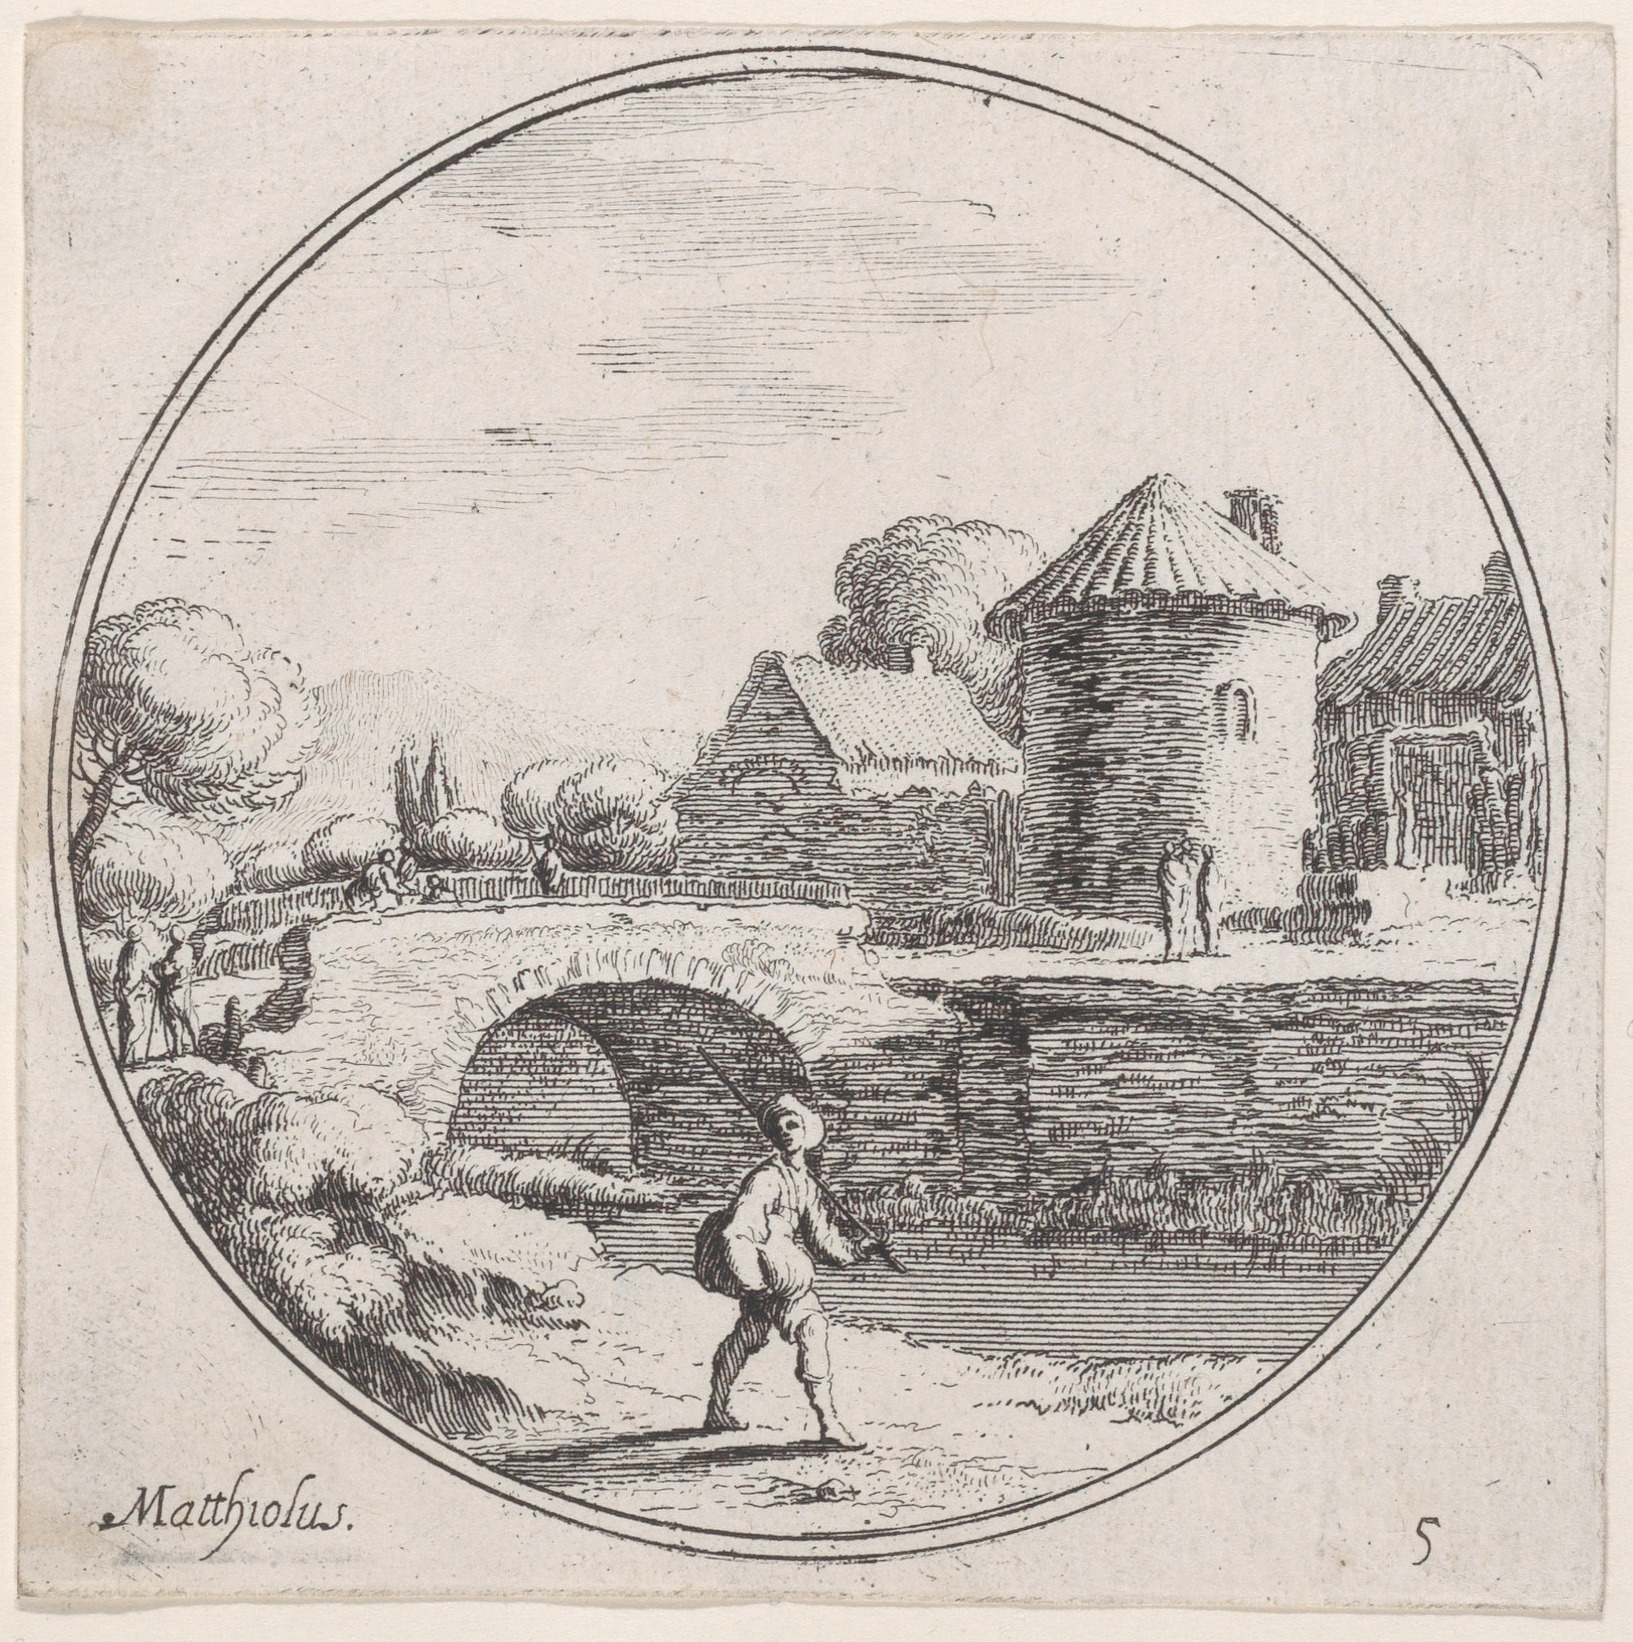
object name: print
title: Plate 5: man walking with fishing pole at center, a bridge and village in the background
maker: lodovico mattioli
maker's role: artist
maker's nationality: italian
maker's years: 1662-1747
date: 1680-1747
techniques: etching